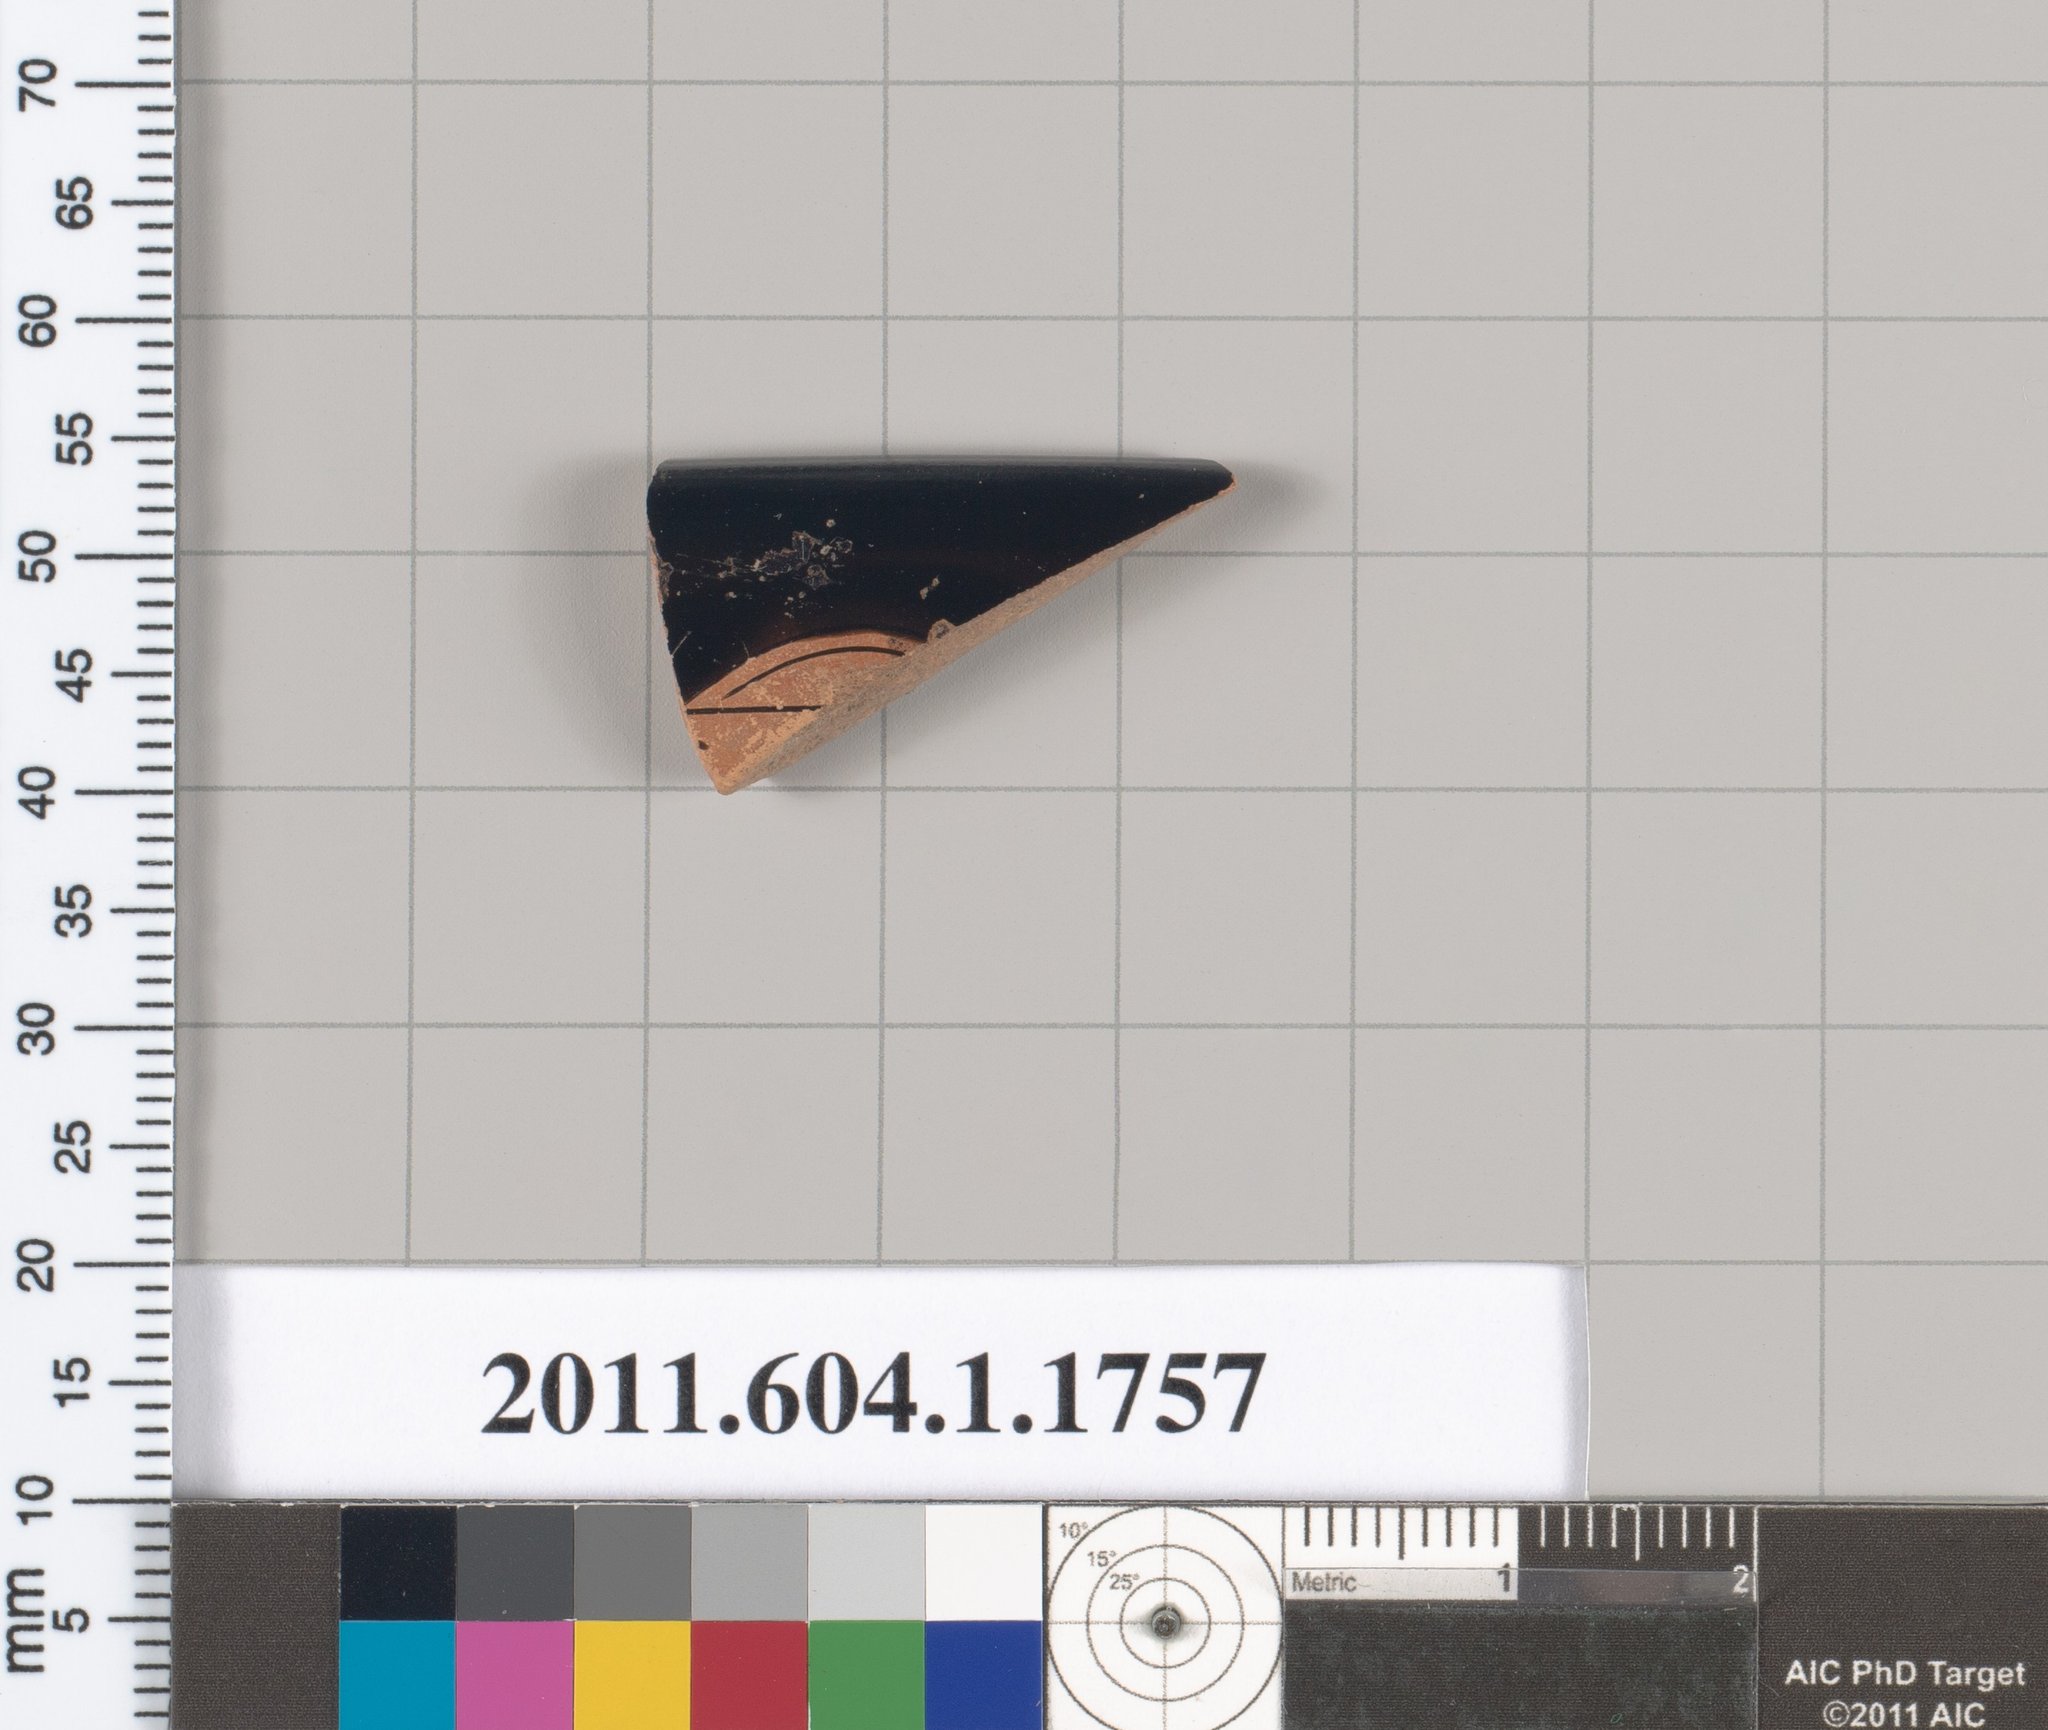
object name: kylix fragment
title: Terracotta rim fragment of a kylix (drinking cup)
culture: greek, attic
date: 475-451 BCE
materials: terracotta